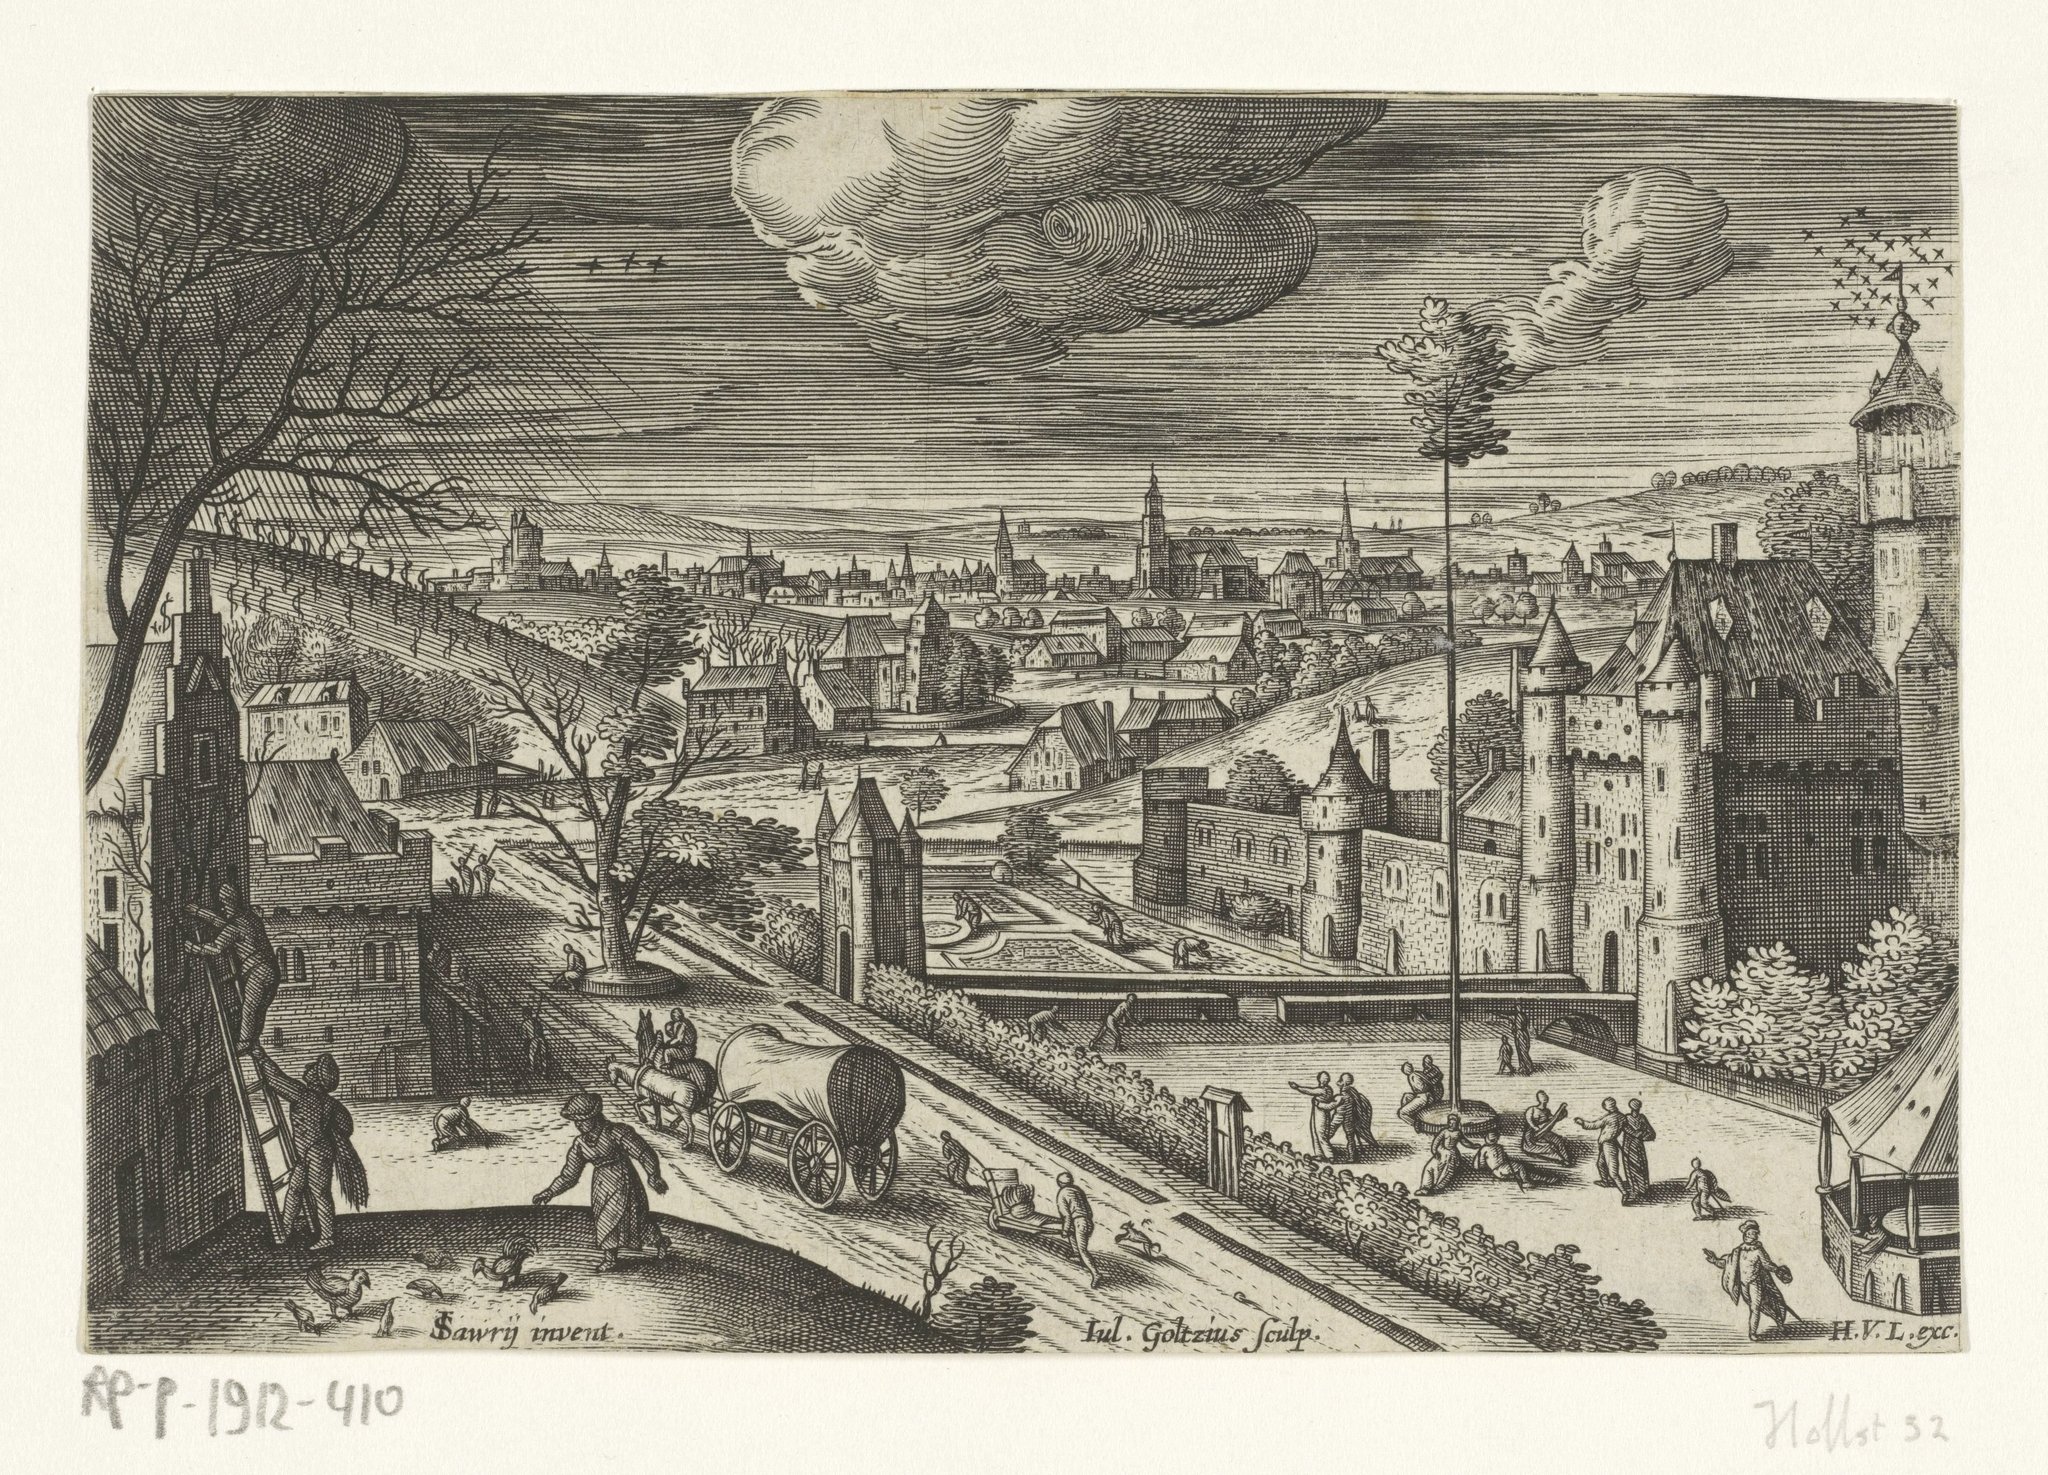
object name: print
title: Landschap met een kasteel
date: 1560-1595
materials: paper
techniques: engraving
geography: antwerp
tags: city-view in general; 'veduta', landscape with tower or castle (+ city(-scape) with figures, staffage)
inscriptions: collector's mark: Lugt 2228, collector's mark: Lugt 2241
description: Een landschap met rechts een kasteel langs een weg. Op de achtergrond een stad. Rechts verzamelen mensen sprokkelhout.